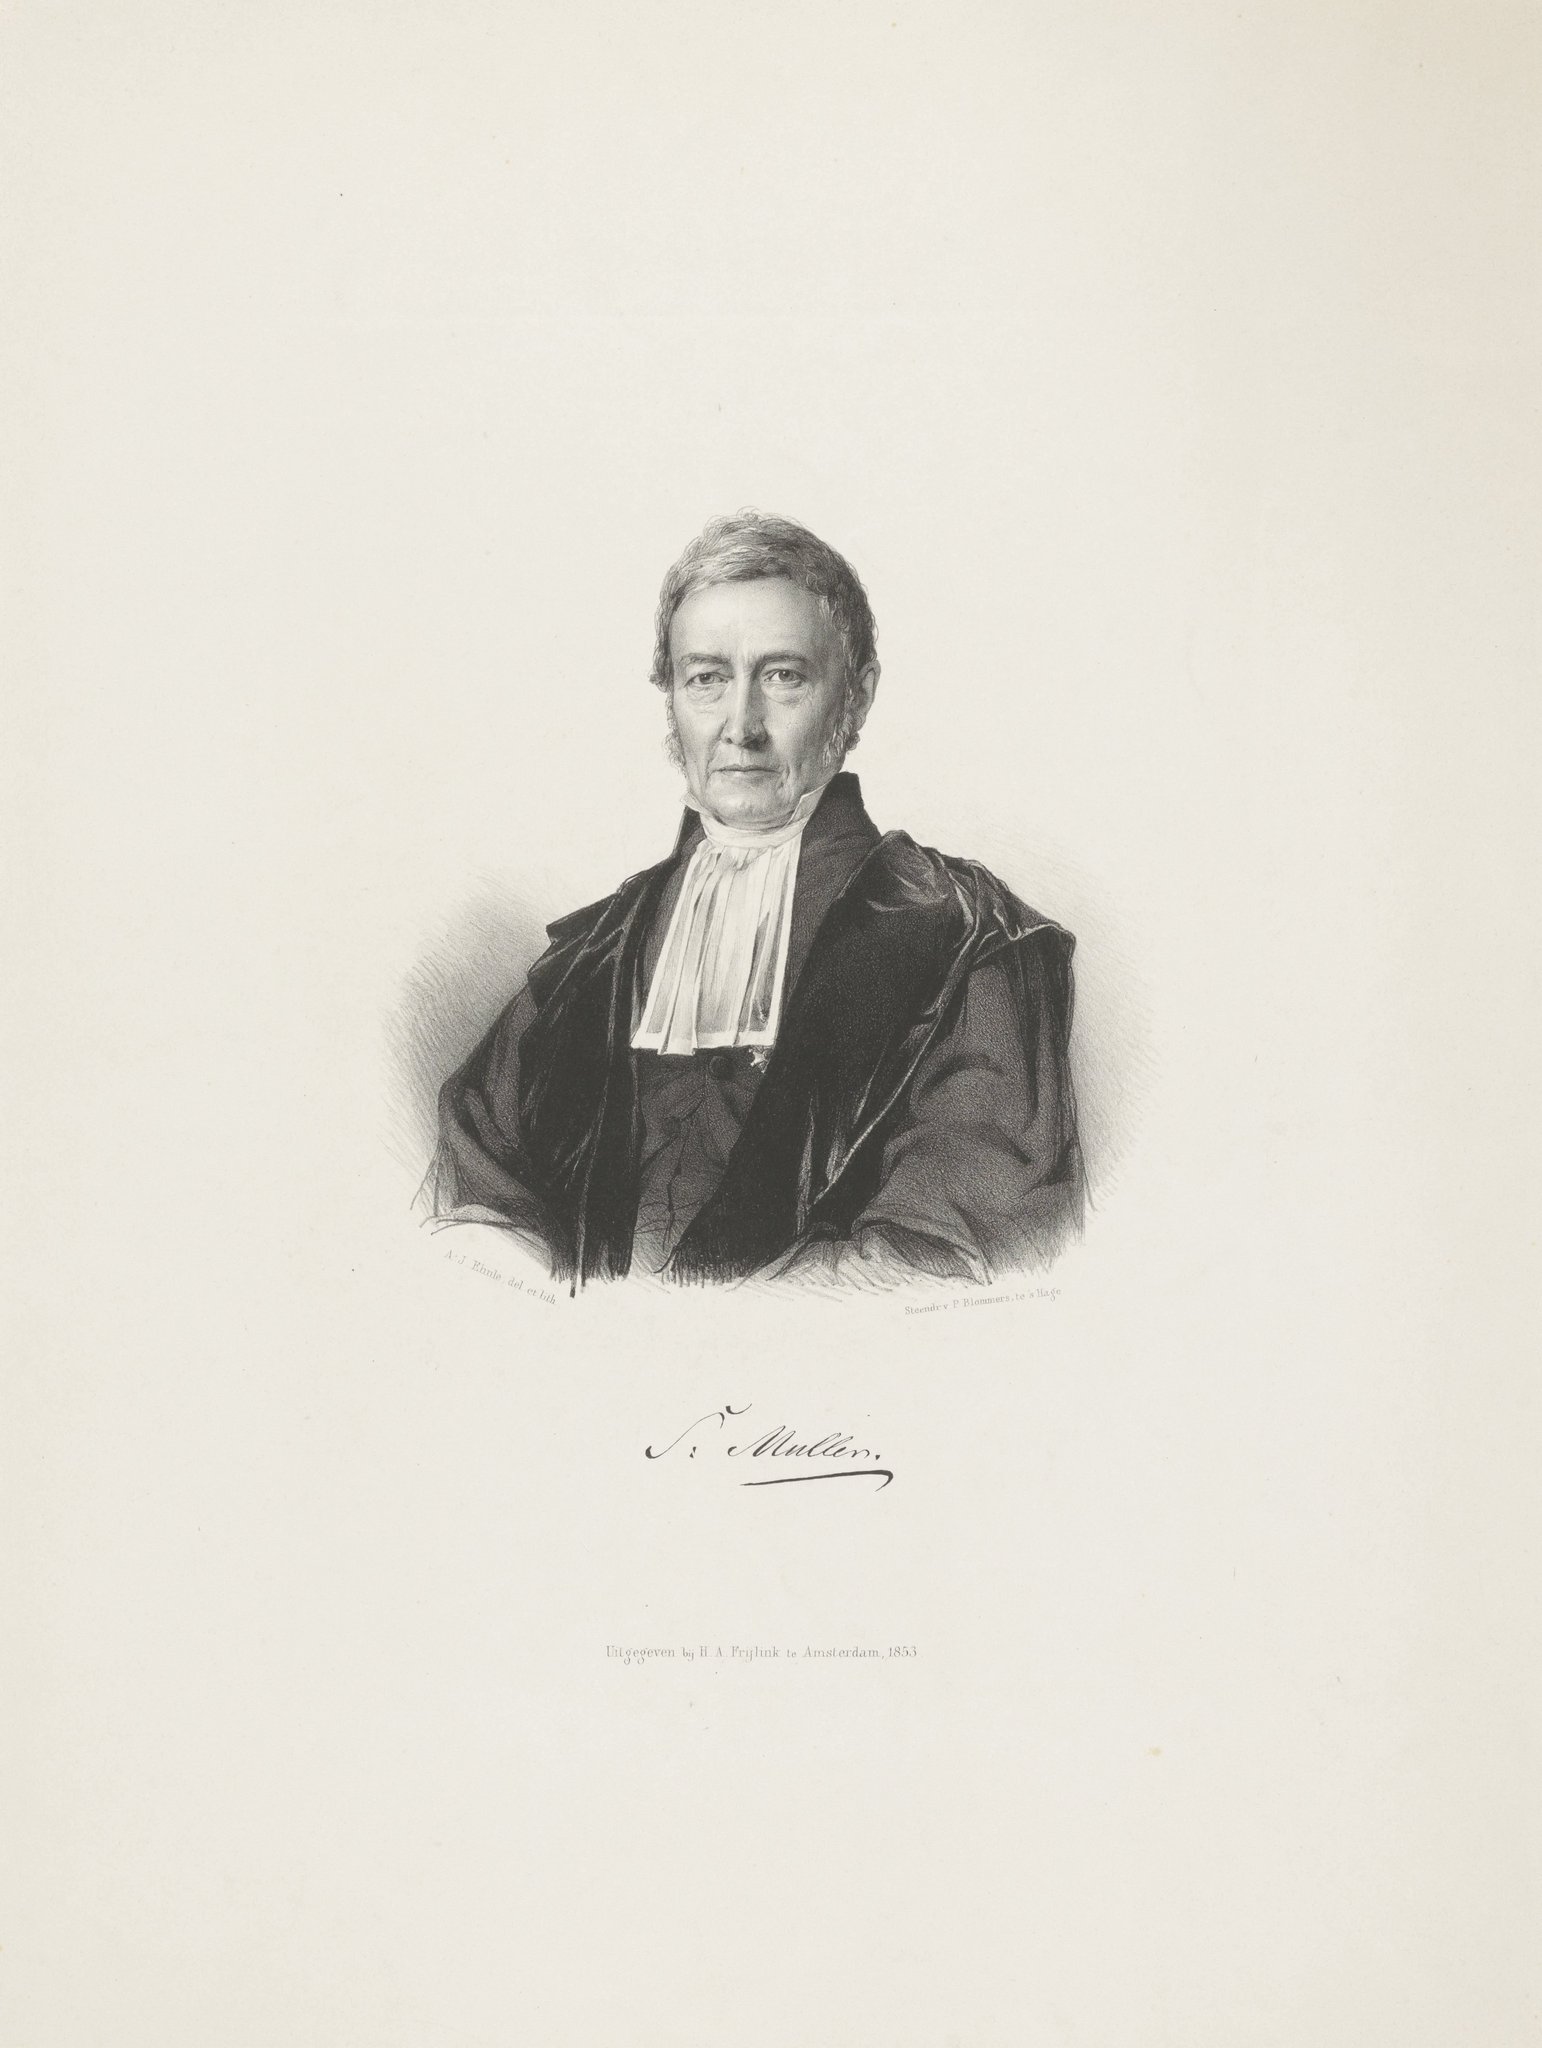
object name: print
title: Portret van S. Muller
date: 1853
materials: paper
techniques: lithograph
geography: amsterdam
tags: amsterdam, samuel muller (1785-1875), historical persons (+ (full) bust portrait)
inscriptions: collector's mark: Lugt 2228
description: De geportretteerde draagt een toga en een bef. Onder het portret zijn signatuur.